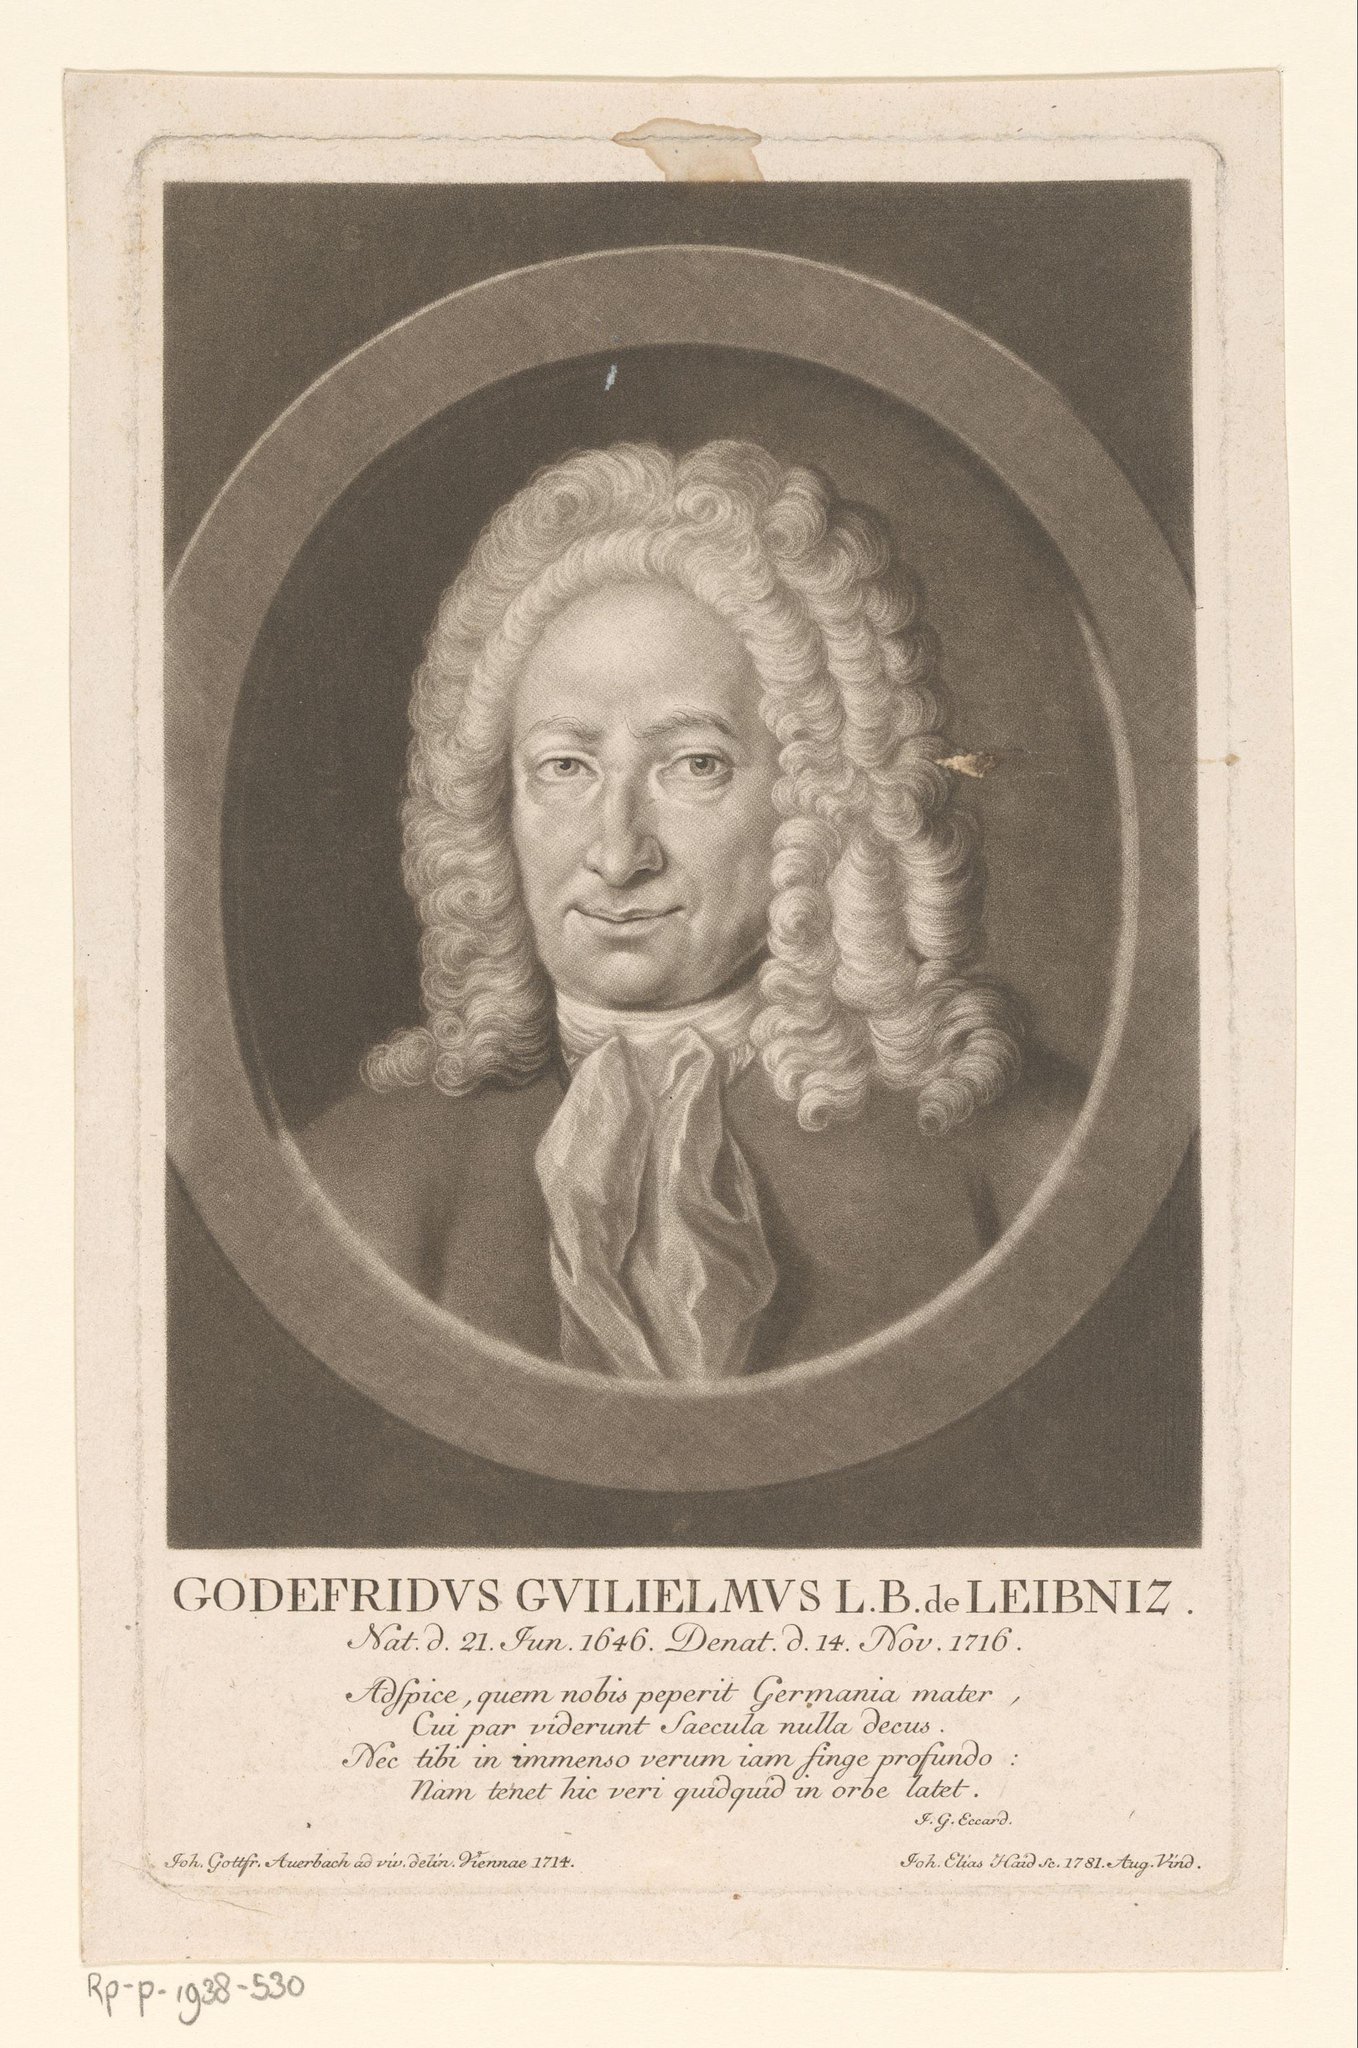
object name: print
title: Portret van Gottfried Wilhelm Leibniz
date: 1714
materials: paper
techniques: mezzotint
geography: vienna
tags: scholar, philosopher, historical persons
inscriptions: collector's mark: Lugt 2228